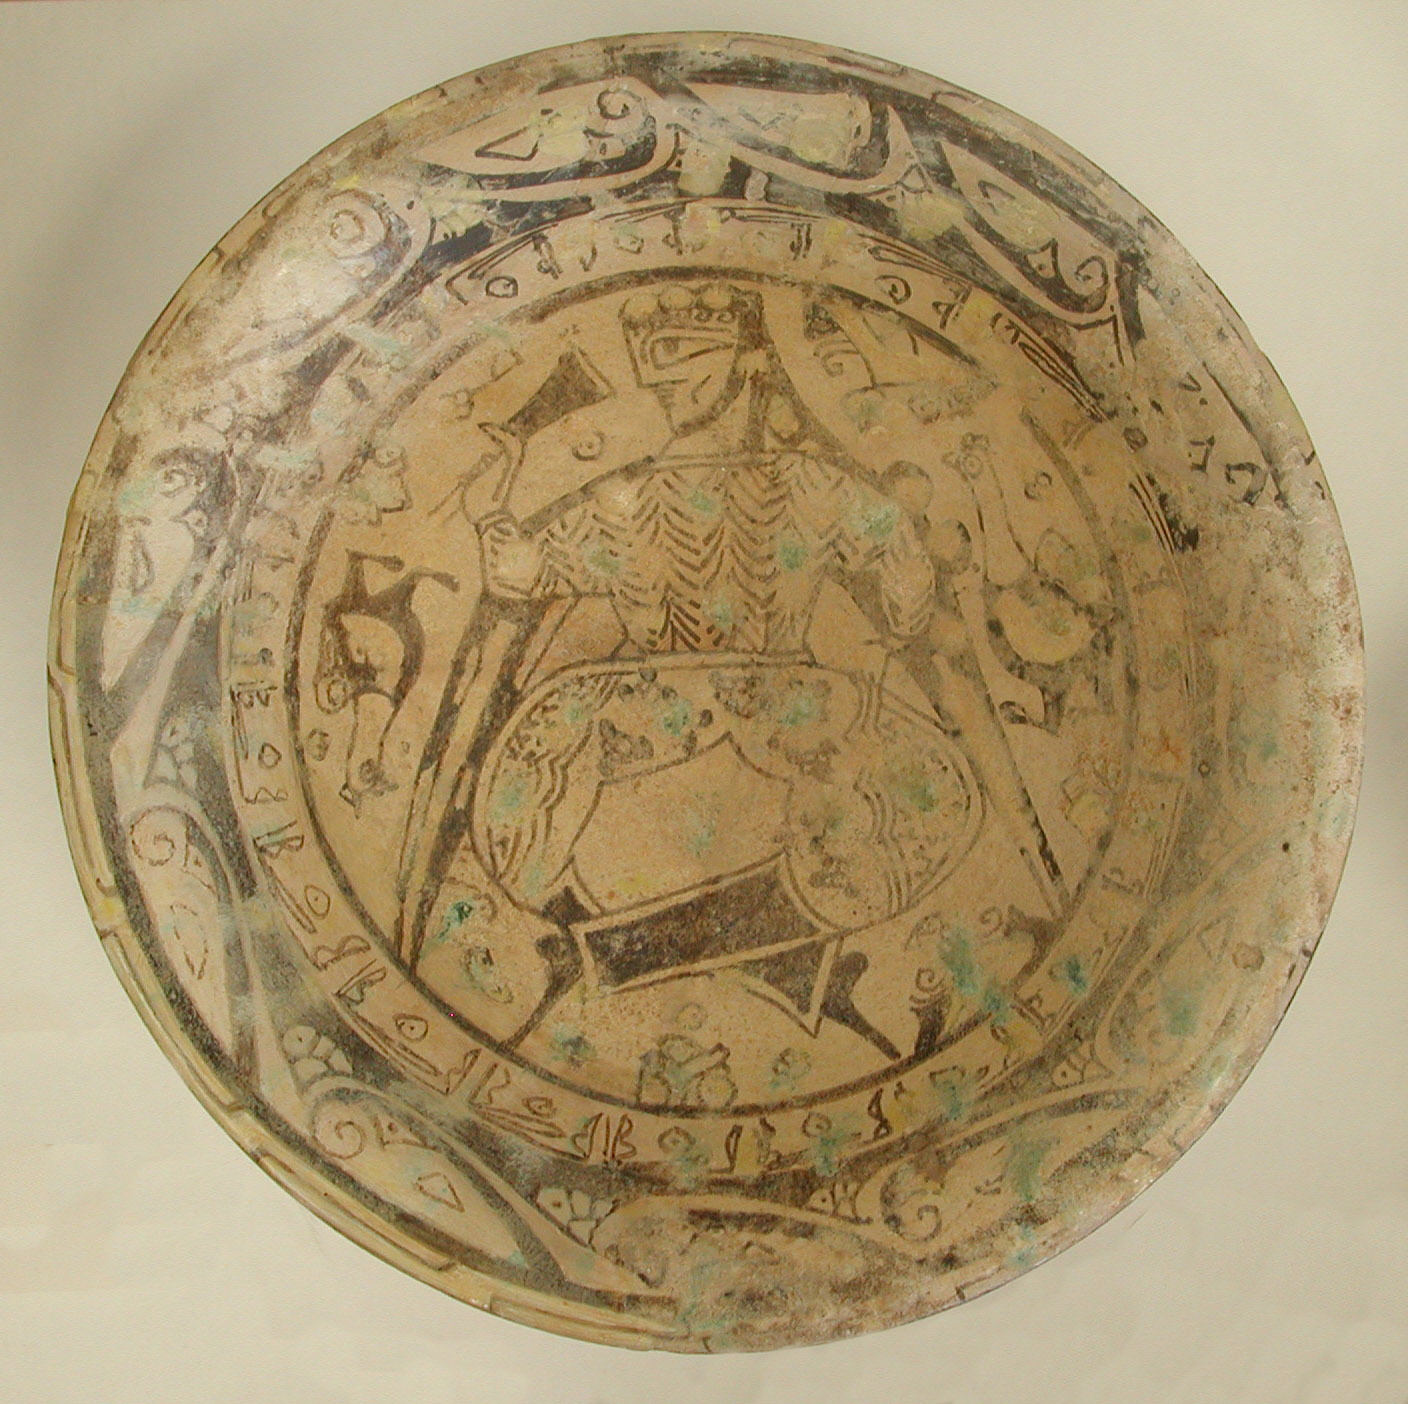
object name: bowl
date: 767-900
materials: earthenware, glaze, pigment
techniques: painting, polychrome, underglaze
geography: iran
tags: birds,men